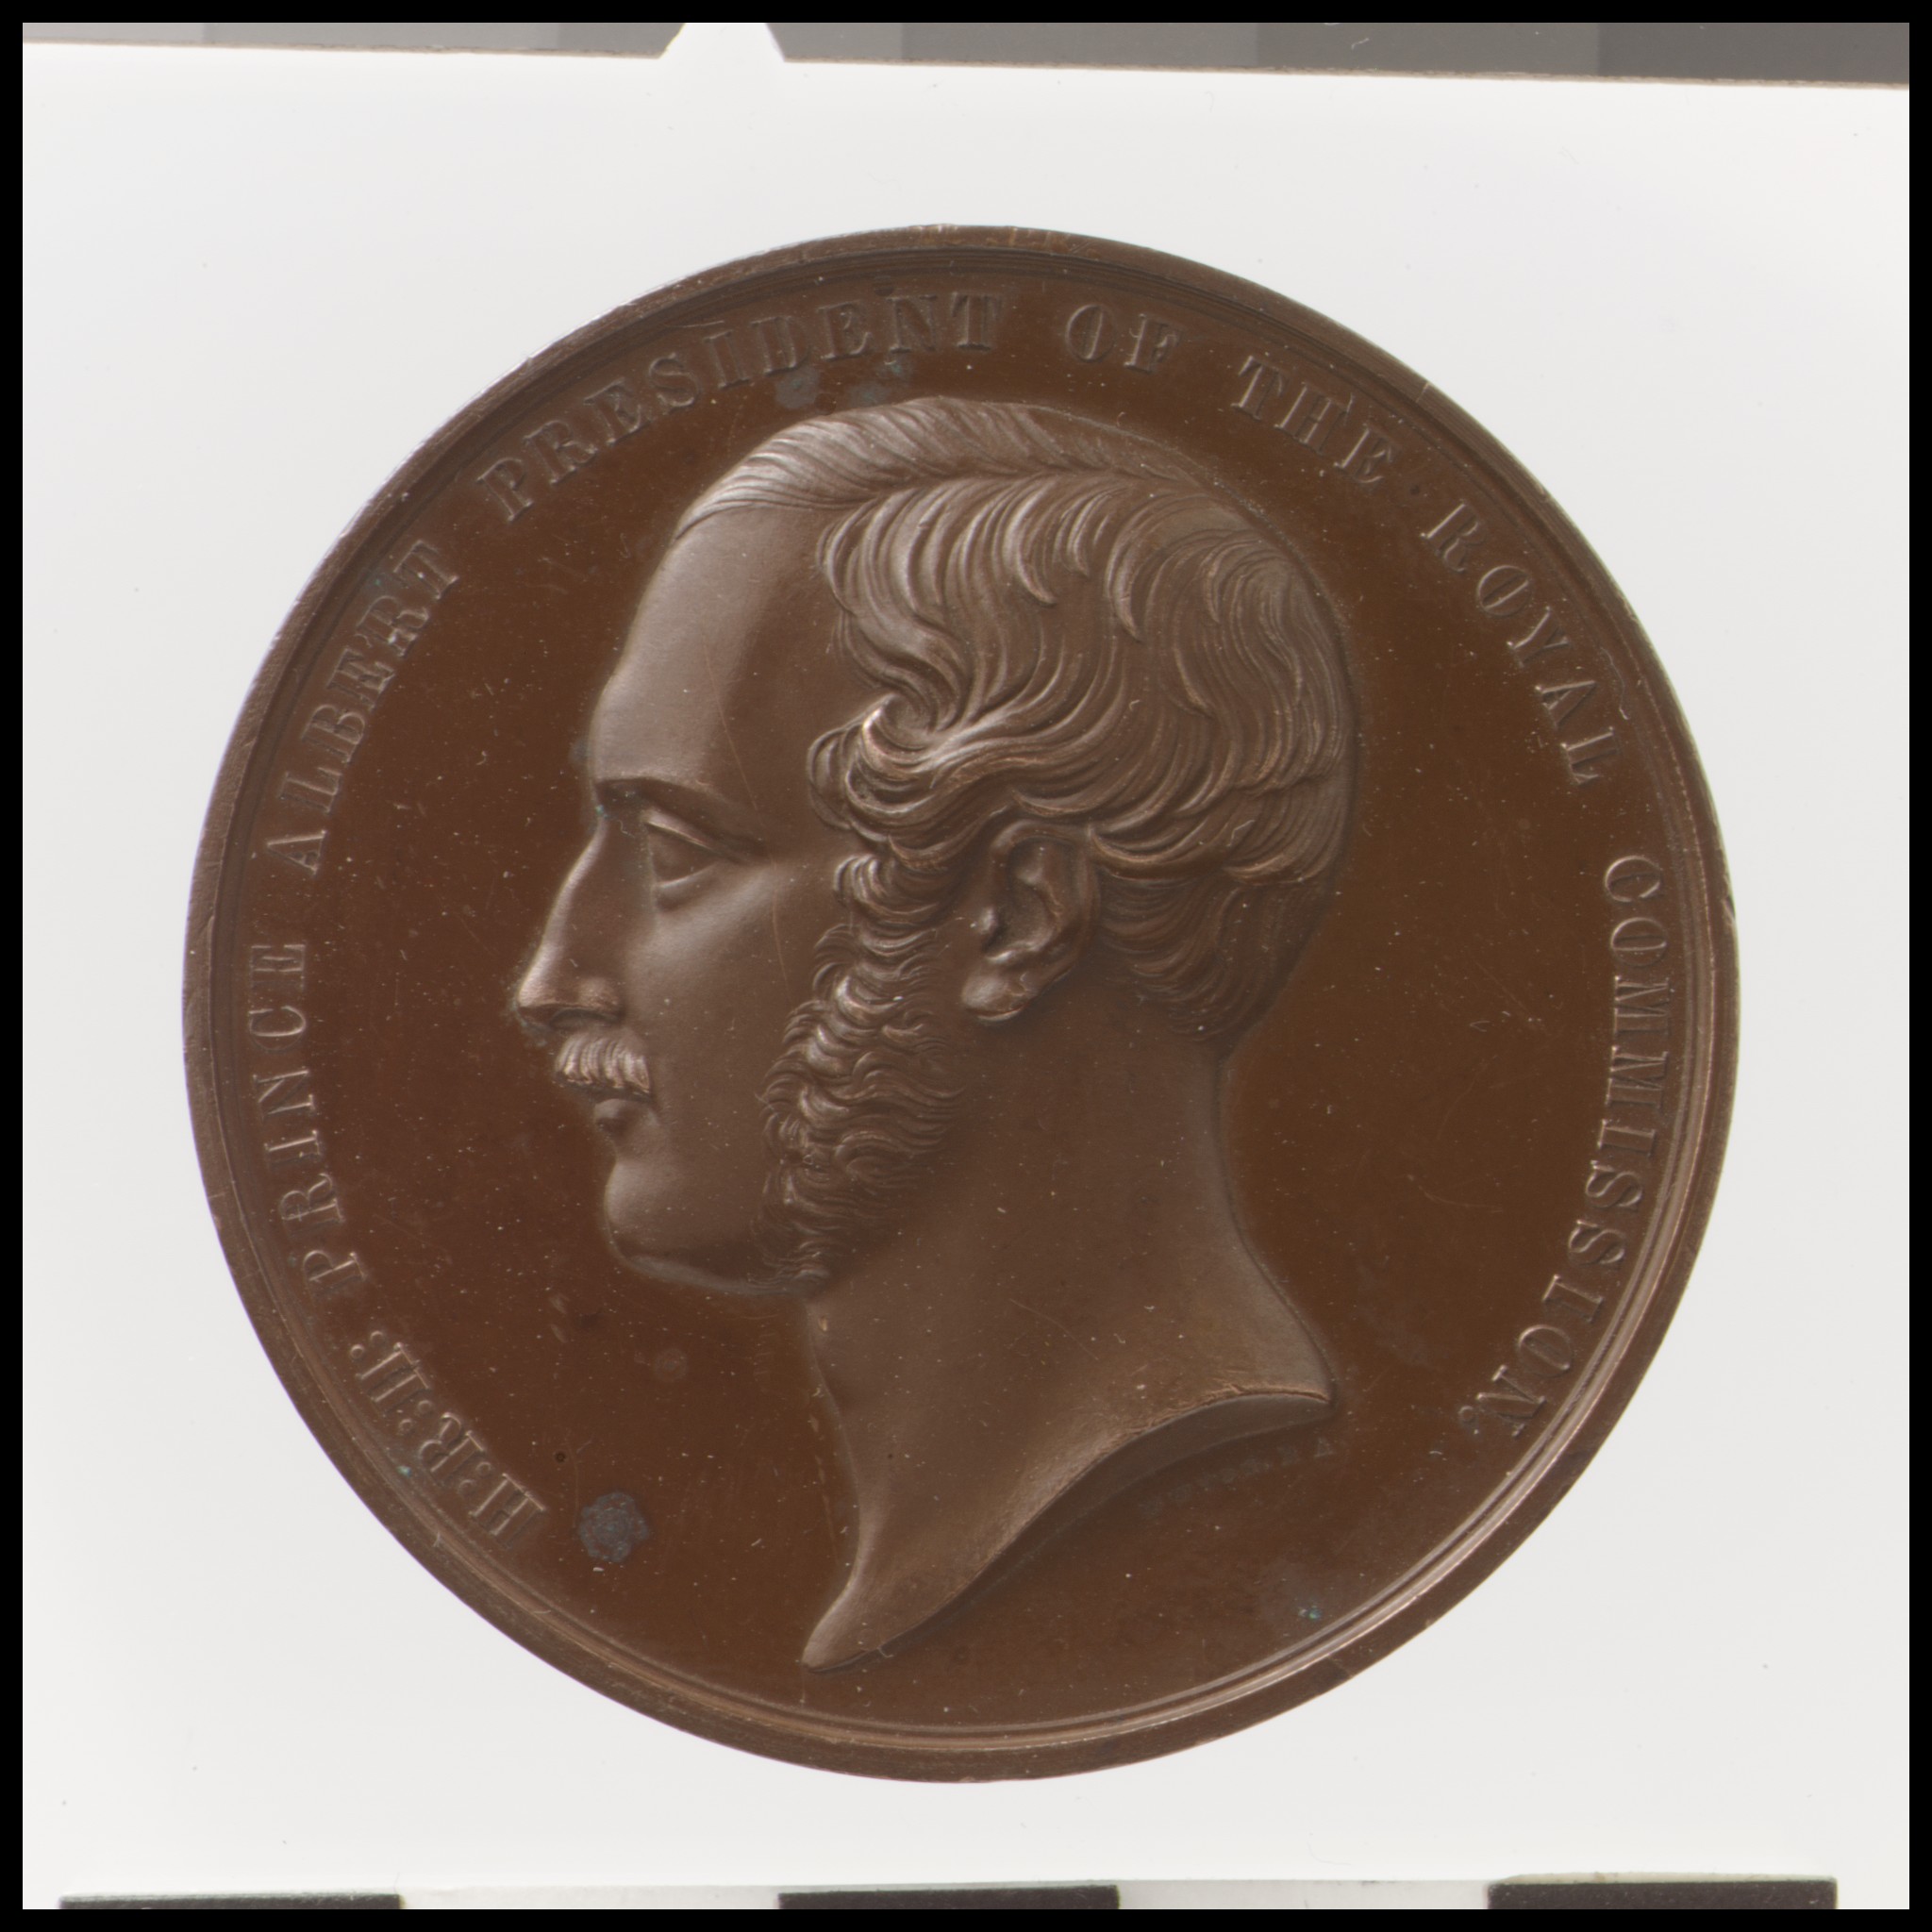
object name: medal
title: Prince Albert, President of the Royal Commission for the Great Exhibition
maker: william wyon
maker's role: artist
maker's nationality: british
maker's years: 1795-1851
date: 1851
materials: bronze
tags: birds,princes,profiles,globes